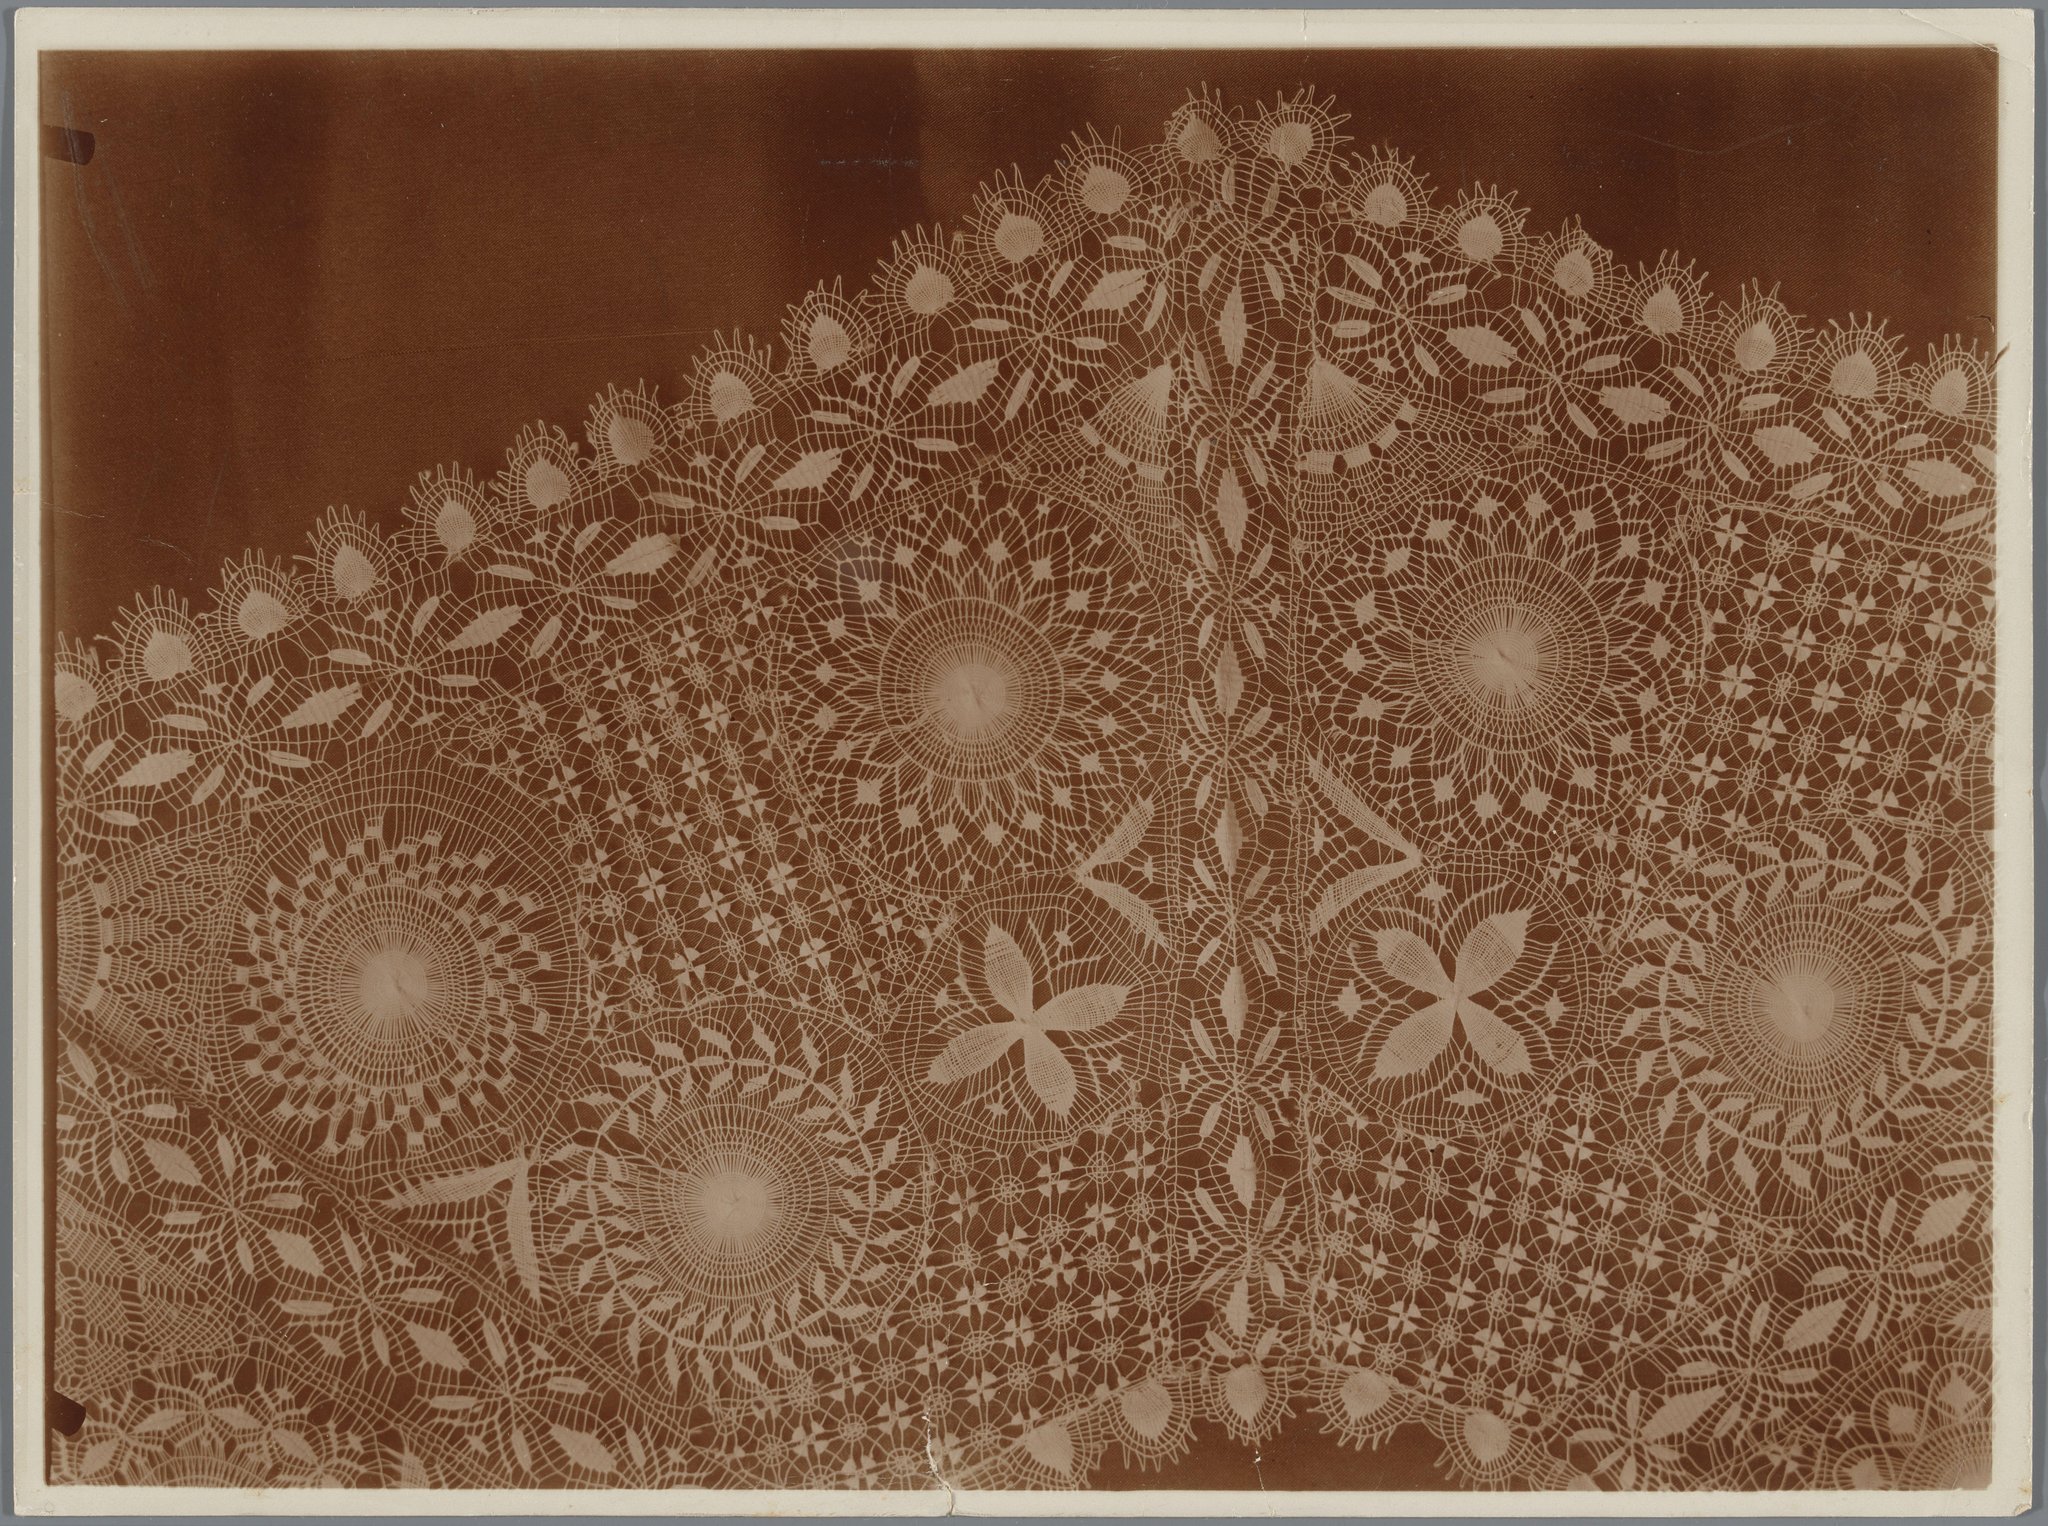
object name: photograph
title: Detail van een kanten doek, mogelijk een kraag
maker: Anonymous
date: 1890-1920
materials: paper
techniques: gelatin silver print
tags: lace